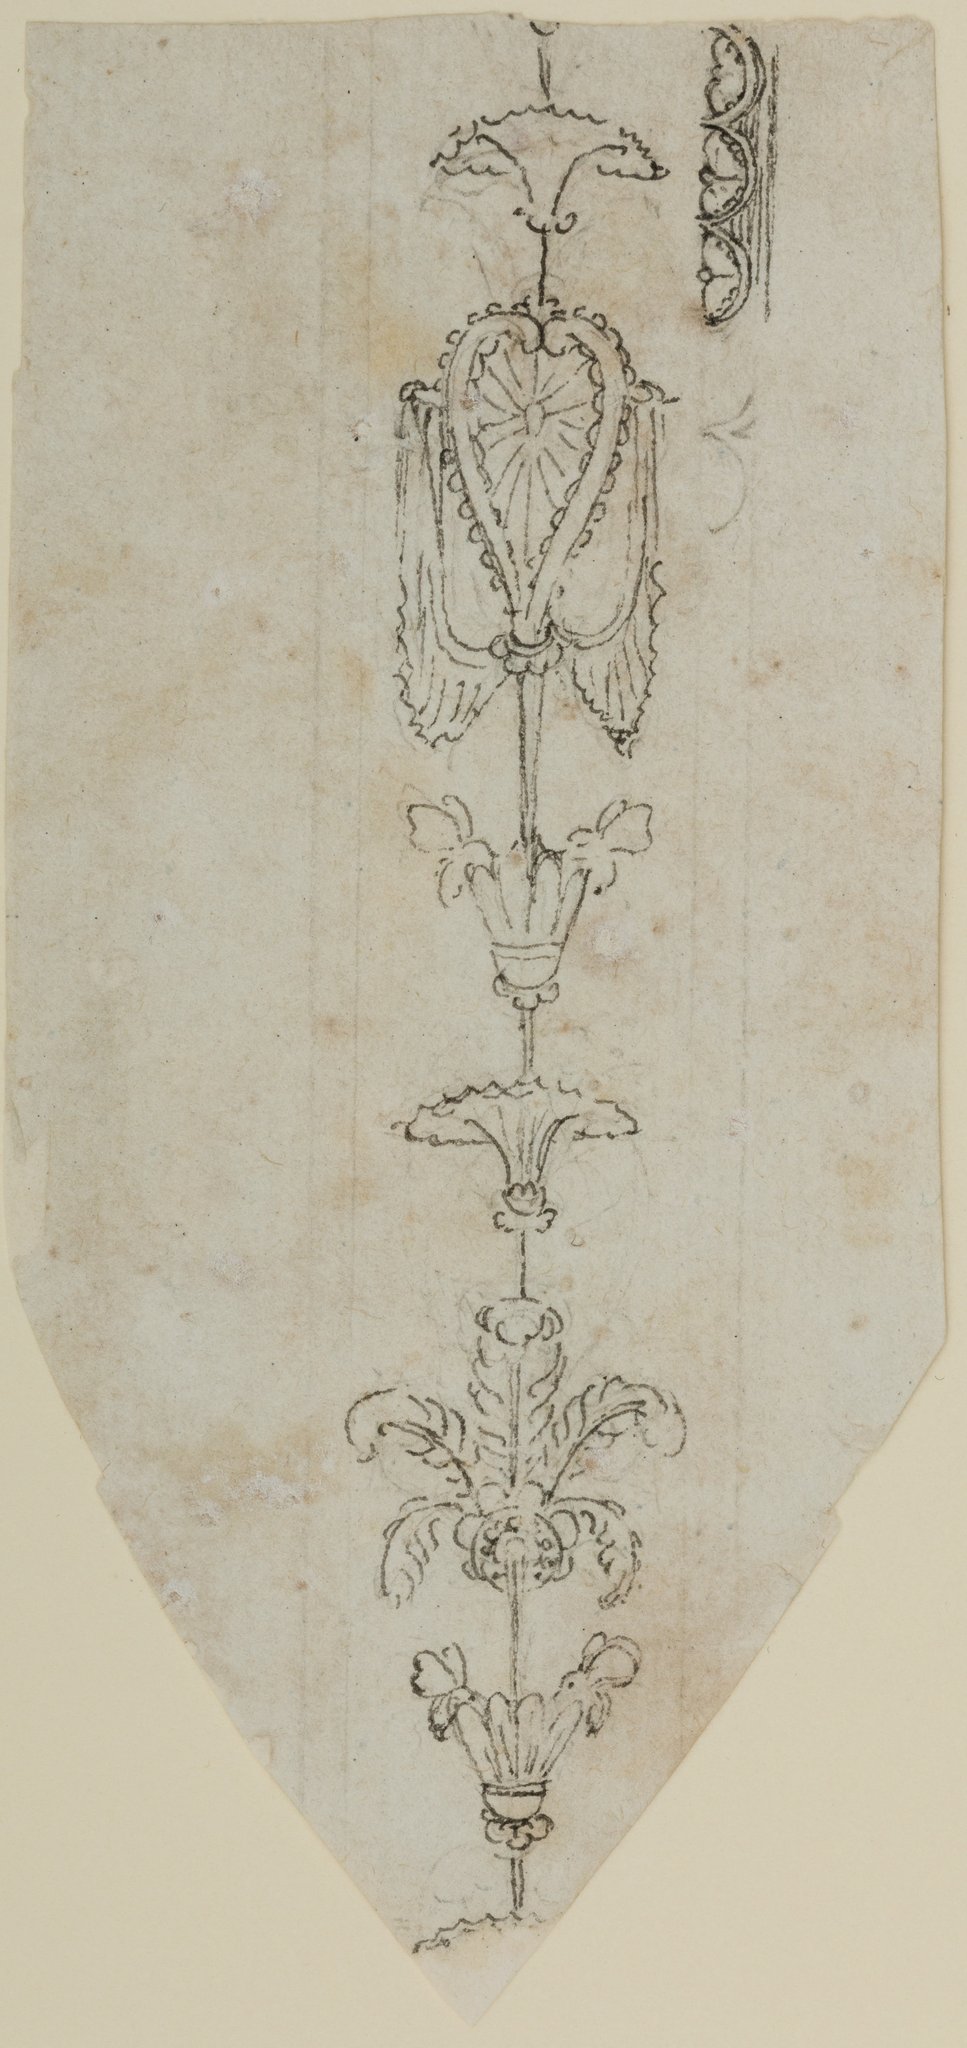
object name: drawing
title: Design for the Decoration of Firearms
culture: french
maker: nicolas noël boutet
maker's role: designer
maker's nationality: french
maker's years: 1761-1833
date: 1797-1805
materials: ink, paper, pencil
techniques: wash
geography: france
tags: ornament